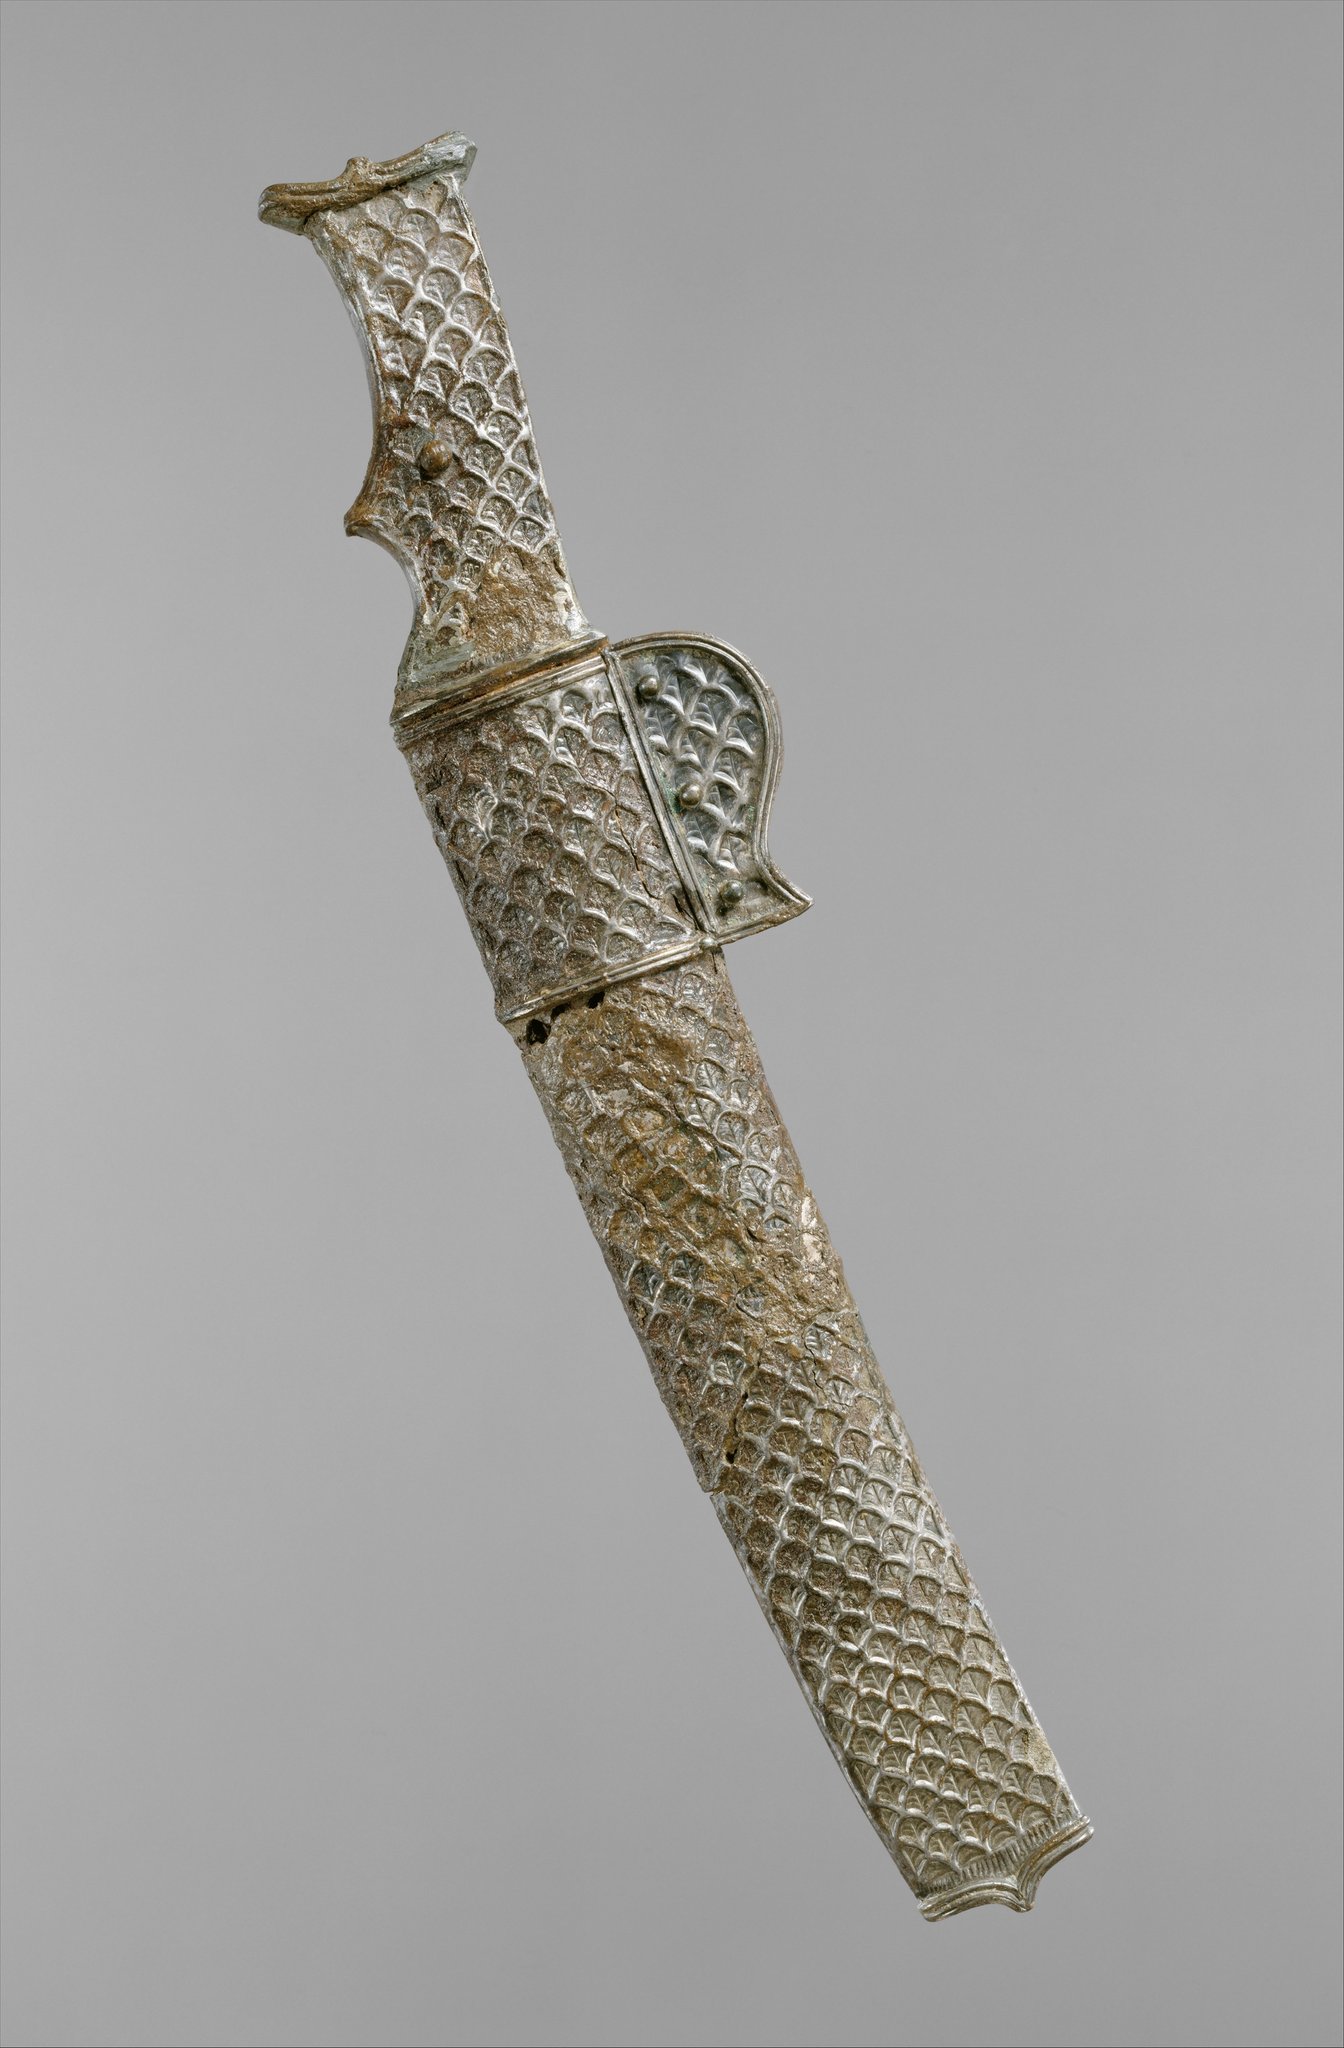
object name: sword with scabbard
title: Short sword and scabbard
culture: sasanian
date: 501-700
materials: iron, silver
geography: iran